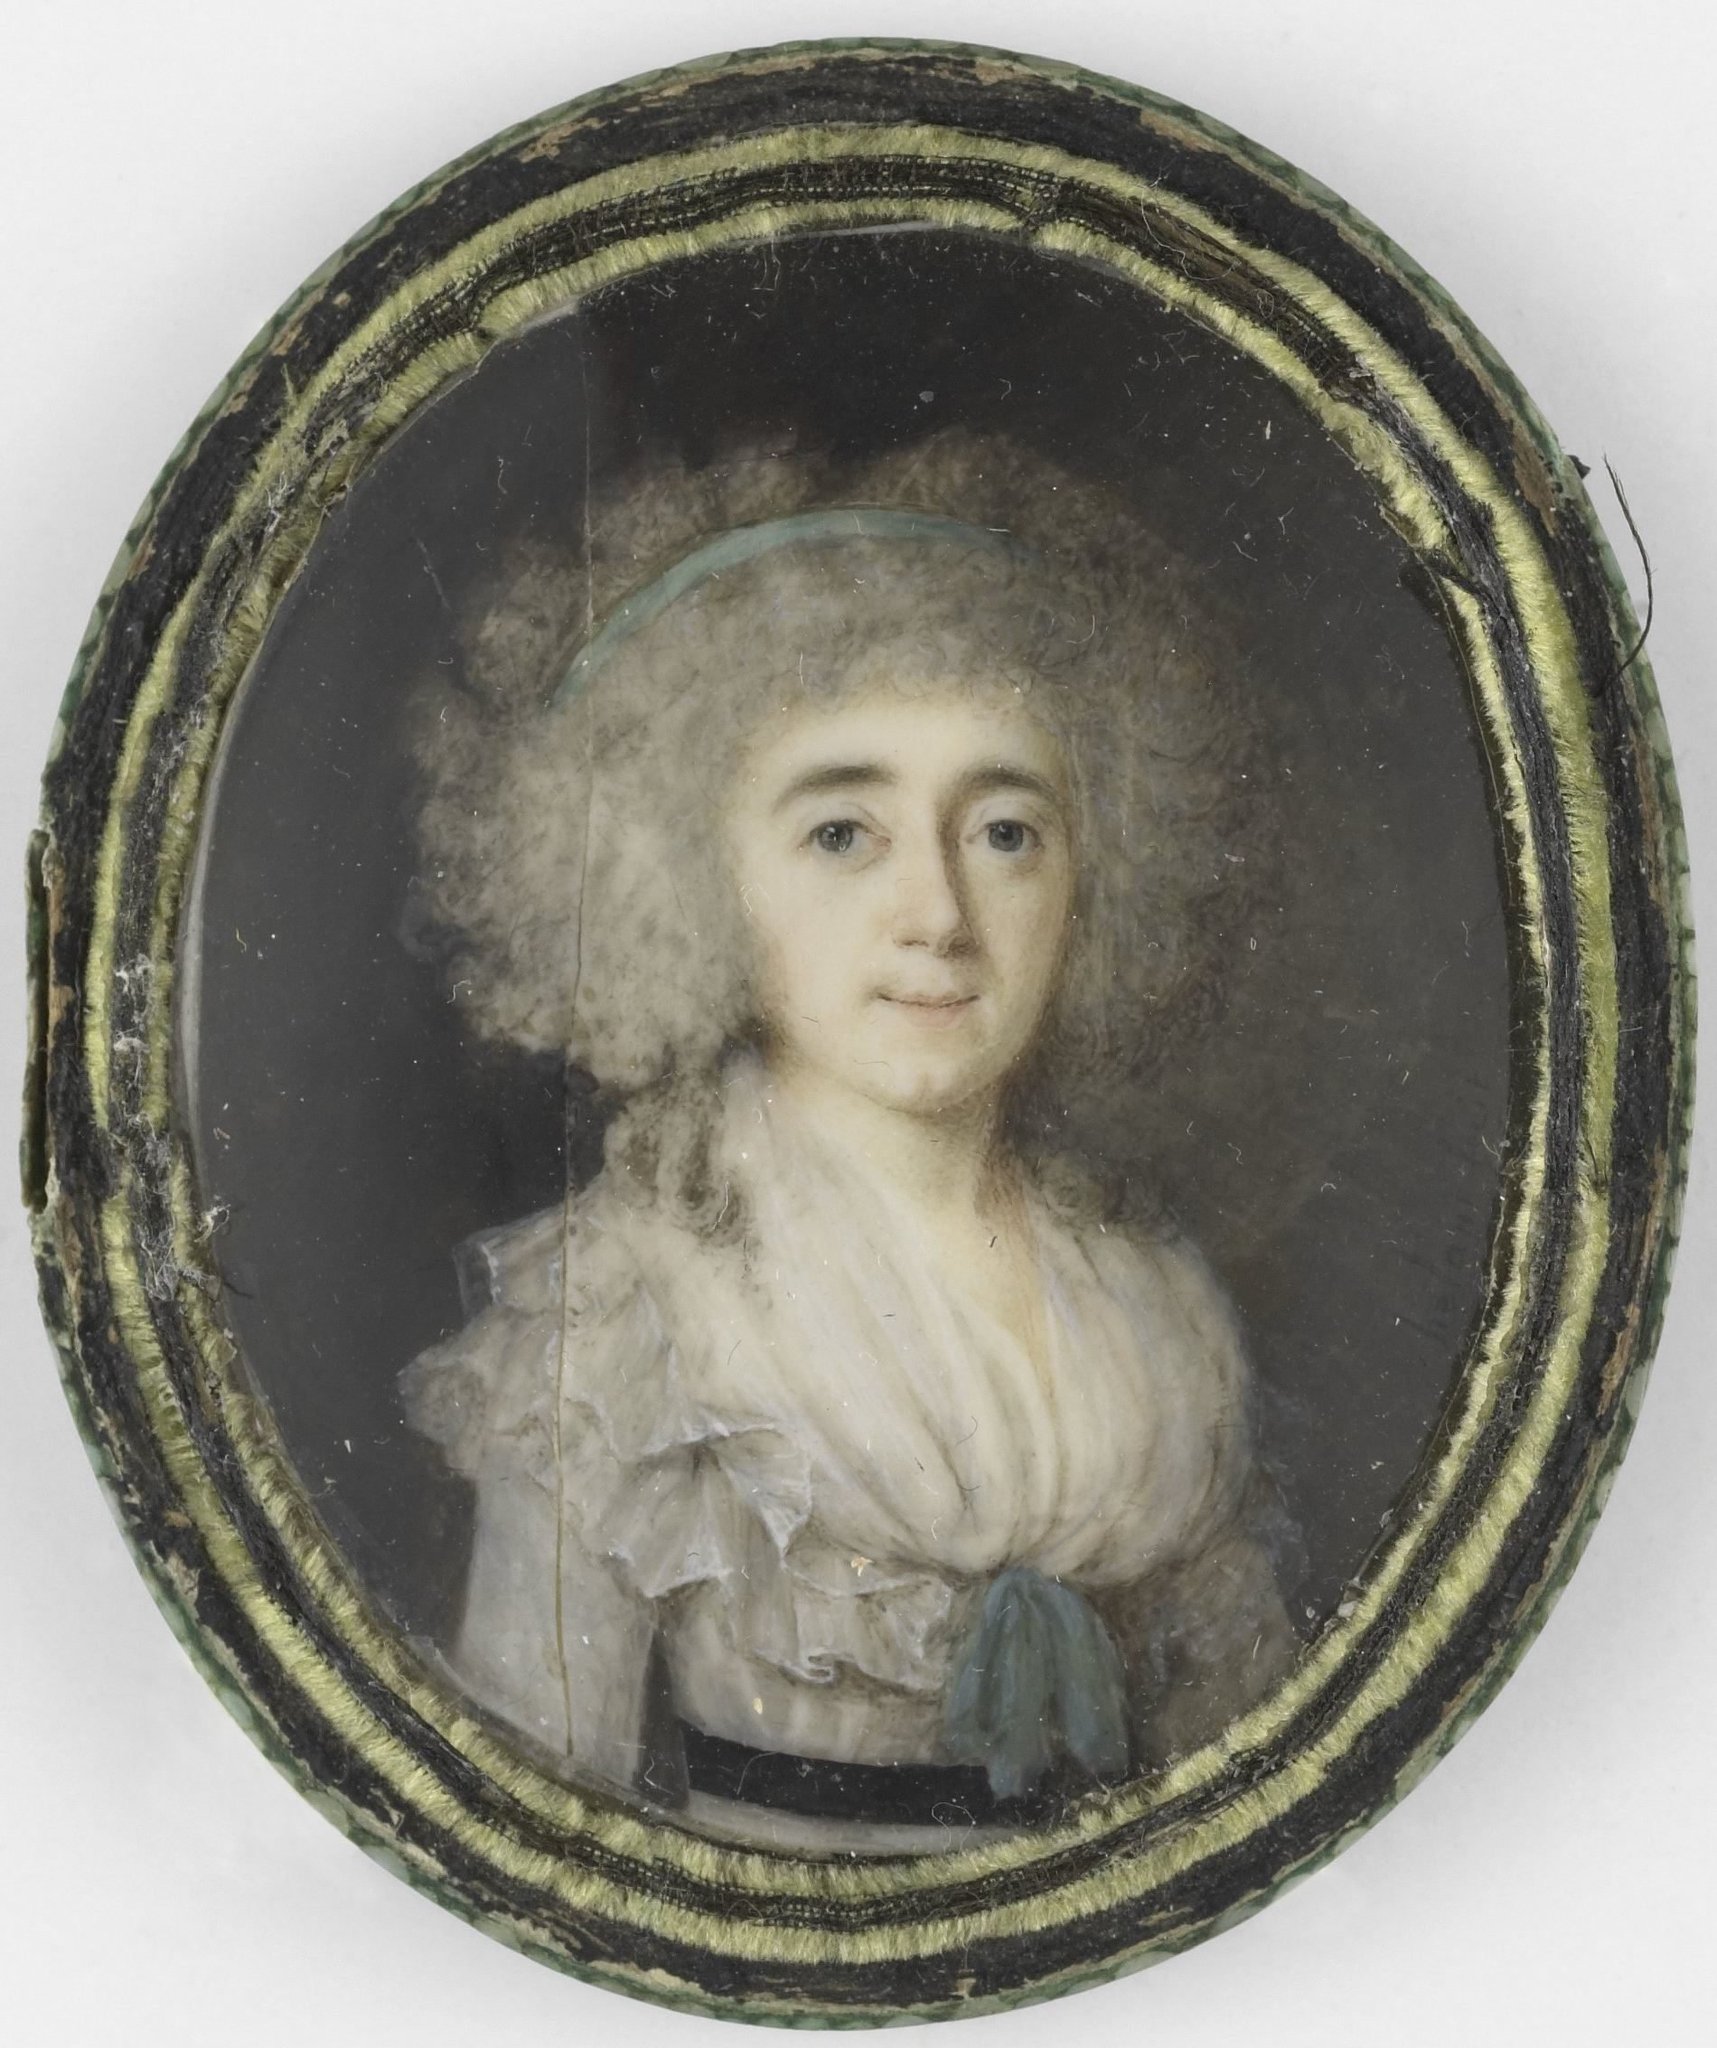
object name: painting, miniature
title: Portrait of a Woman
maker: anthonie joseph helant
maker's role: painter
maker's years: 1751-1847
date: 1790-1800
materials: glass, ivory, textile, watercolor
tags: historical persons not known by name - bb - woman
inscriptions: signature: ‘helant fecit’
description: Antonie Joseph Helant (c. 1752 - c. 1837). Portrait of a woman. Ivory, in anoval case, covered with..., of which lid and hinge are missing, c. 1790